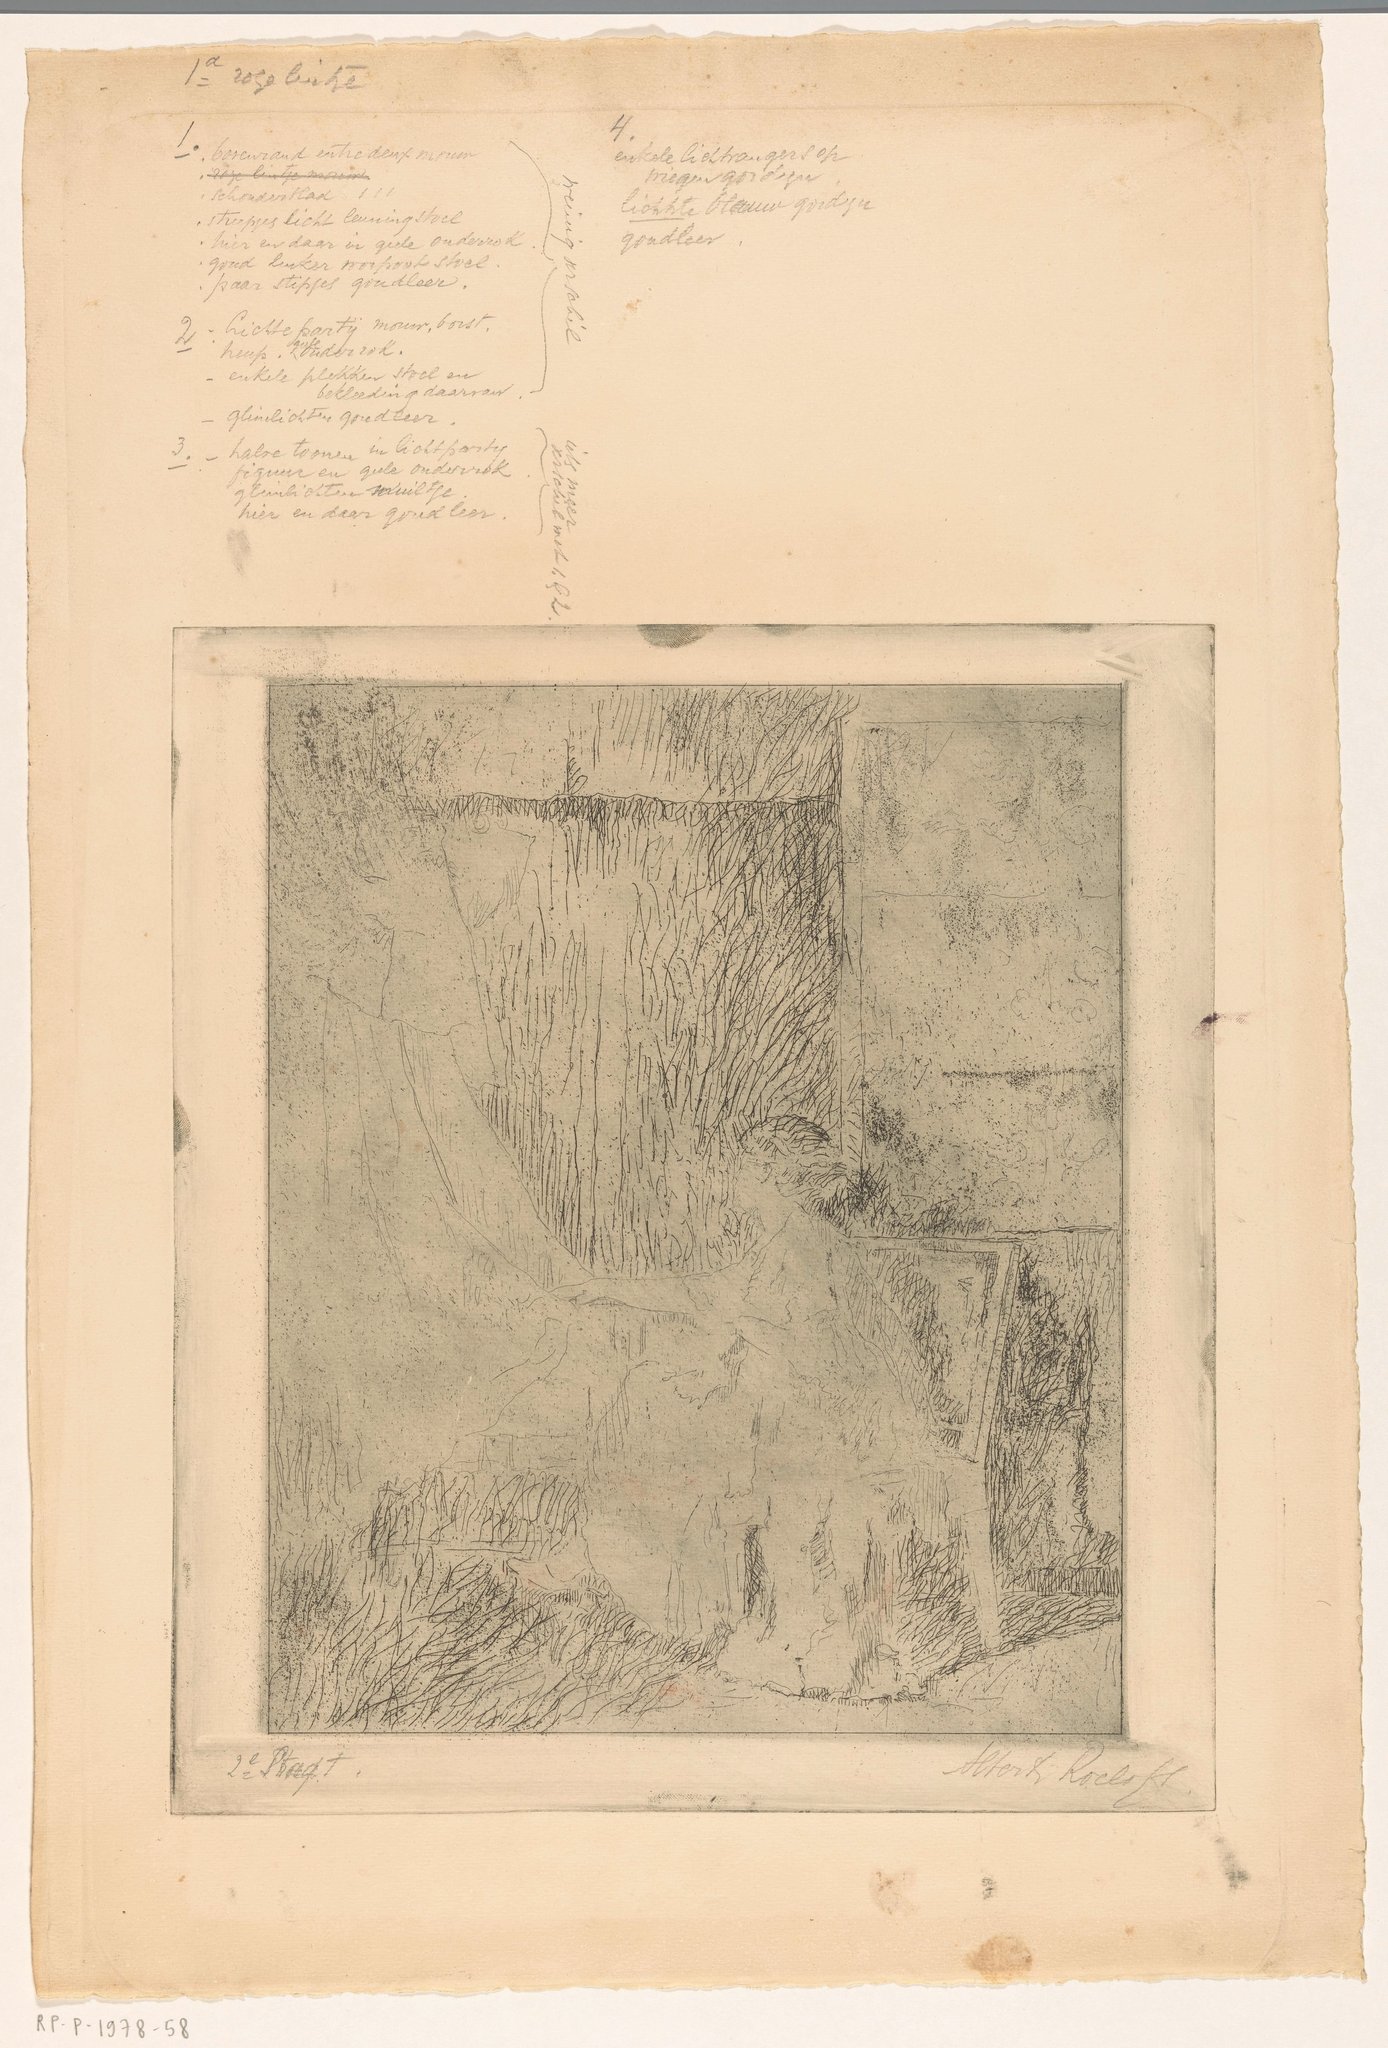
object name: print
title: Vrouw die op een stoel naast een wieg zit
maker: albert roelofs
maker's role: print maker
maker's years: 1877-1920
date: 1887-1920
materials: paper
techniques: etching, intaglio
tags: cradle, crib, mother and child(ren), woman and child(ren) (family group)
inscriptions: collector's mark: Lugt 2228, collector's mark: Lugt 2760, inscription: ‘1a [...] / 1. bovenrand entre deux (...)’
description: De vrouw leunt met haar arm op de rand van de wieg.